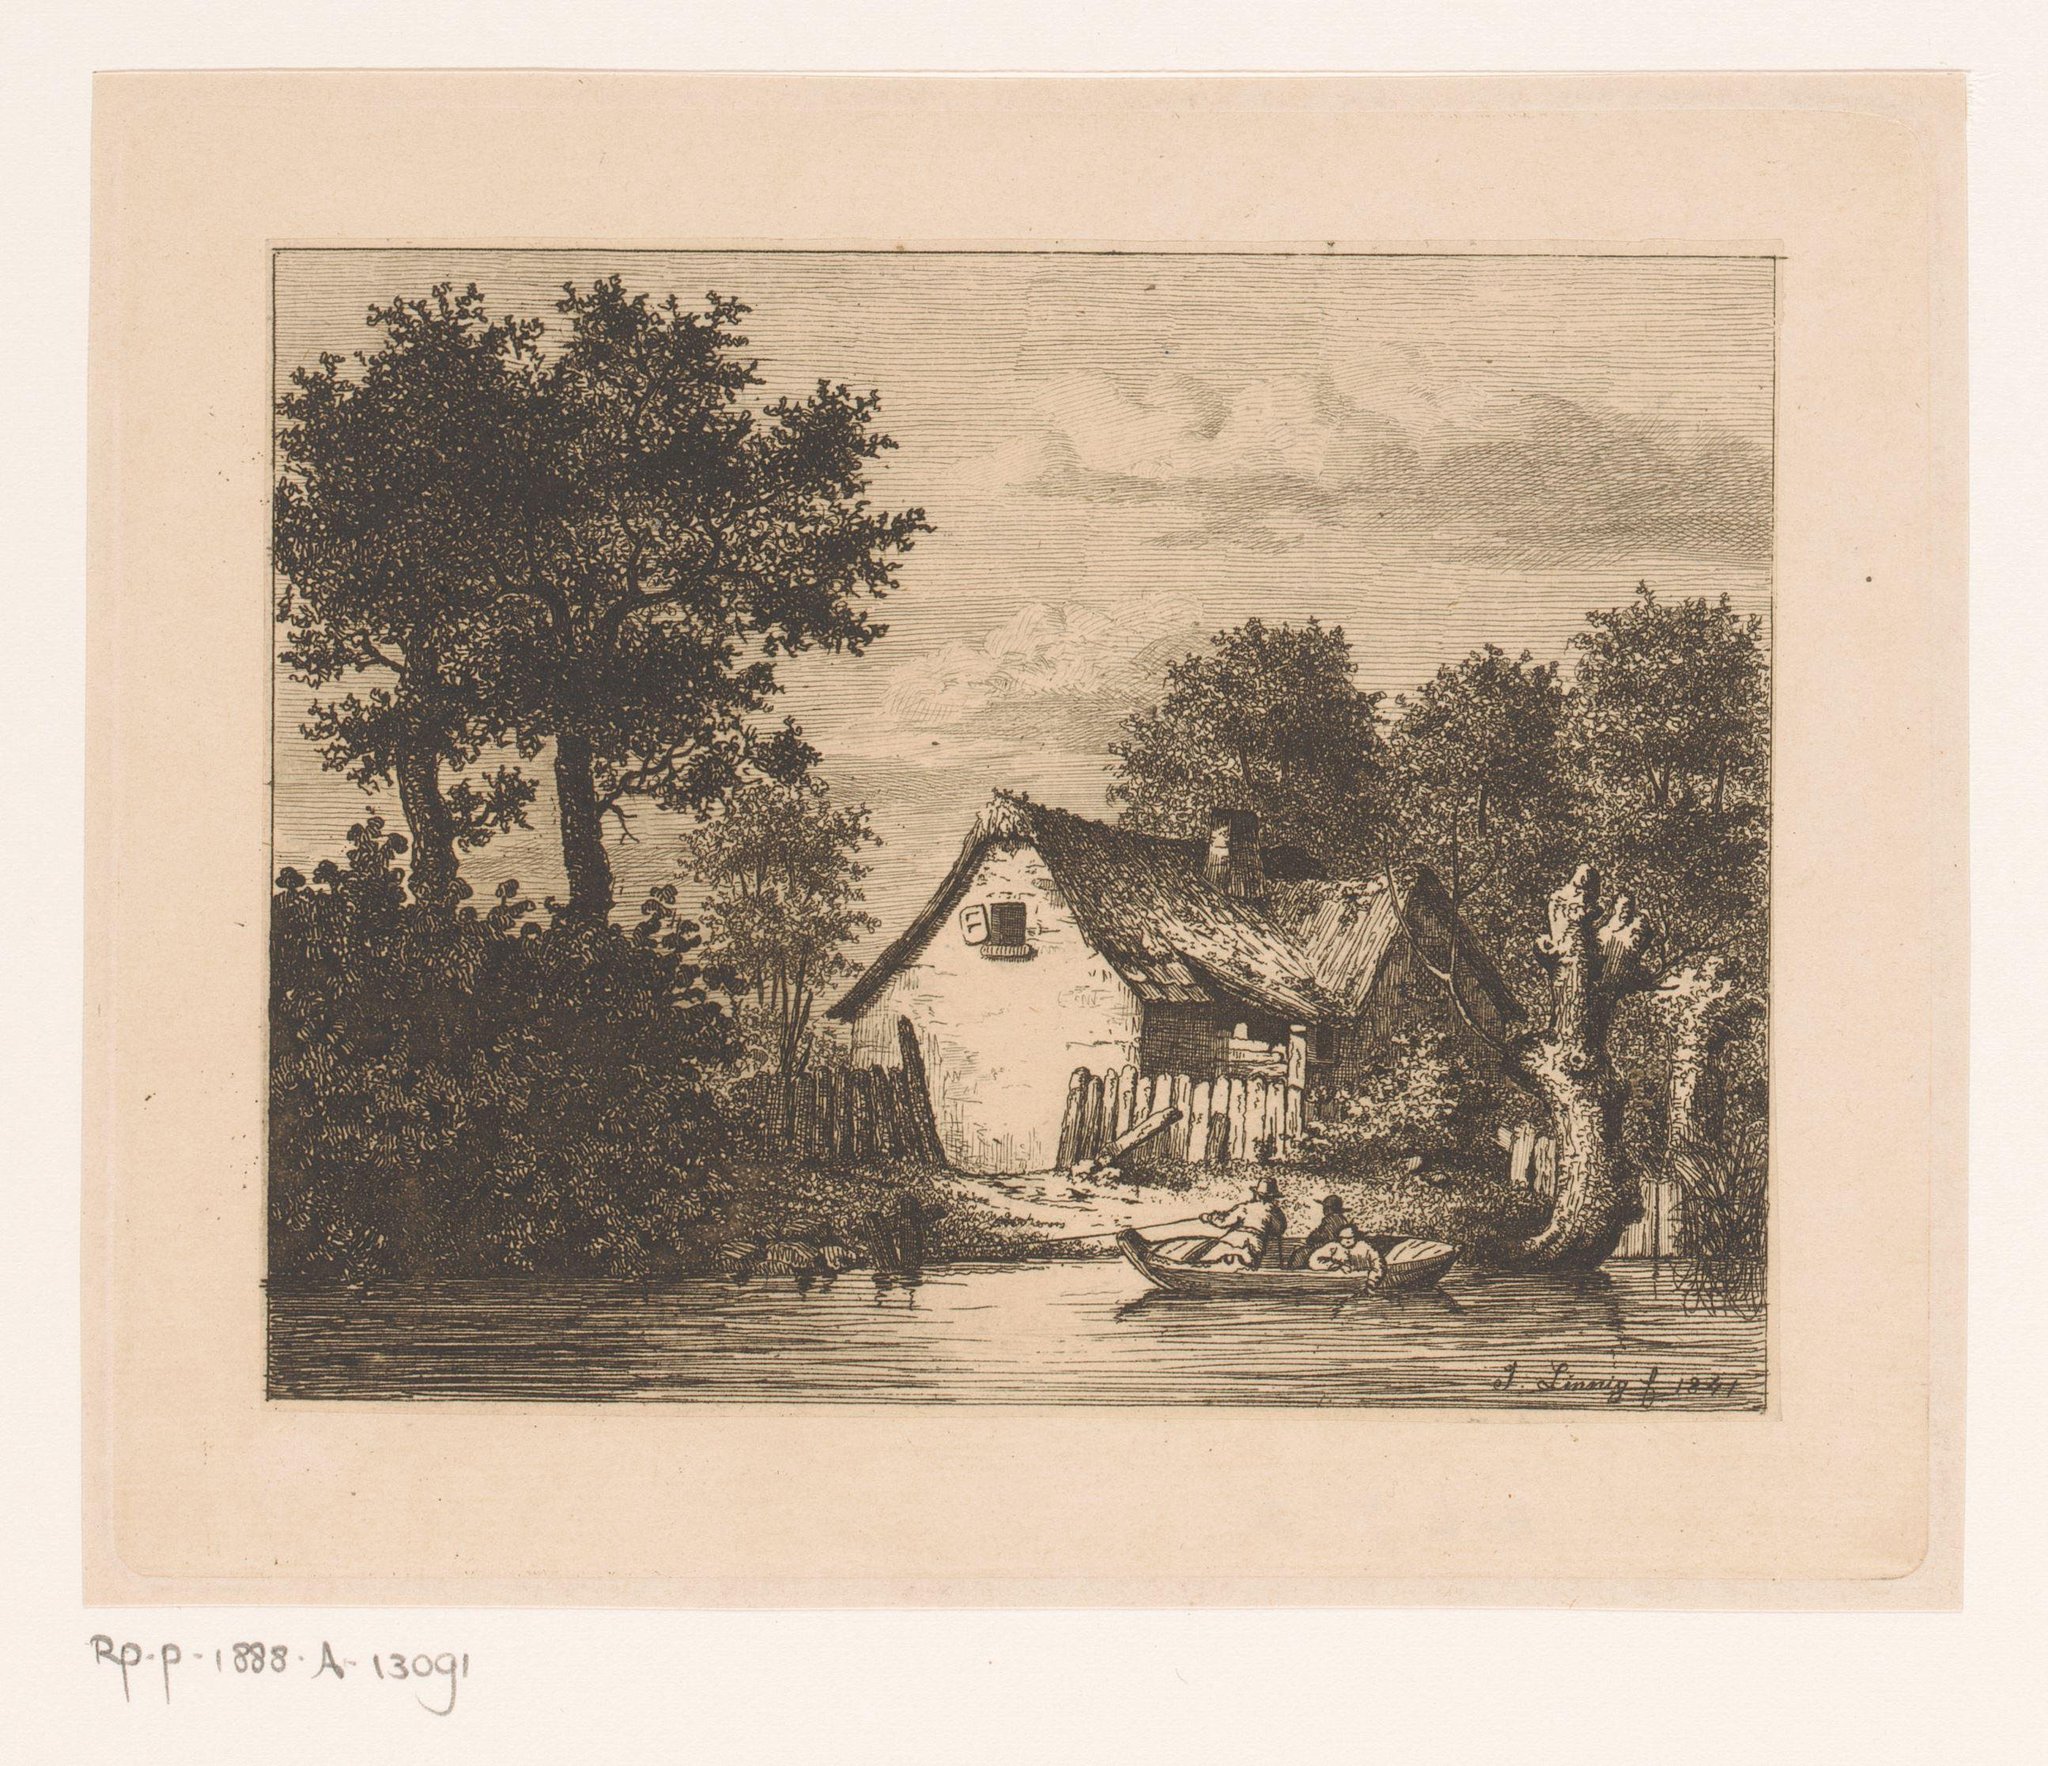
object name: print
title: Roeiboot op een rivier voor een boerderij in Wetteren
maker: jean théodore joseph linnig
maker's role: draughtsman, print maker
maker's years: 1815-1891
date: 1841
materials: paper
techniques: etching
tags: rowing-boat, canoe, etc., farm or solitary house in landscape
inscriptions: collector's mark: Lugt 2228